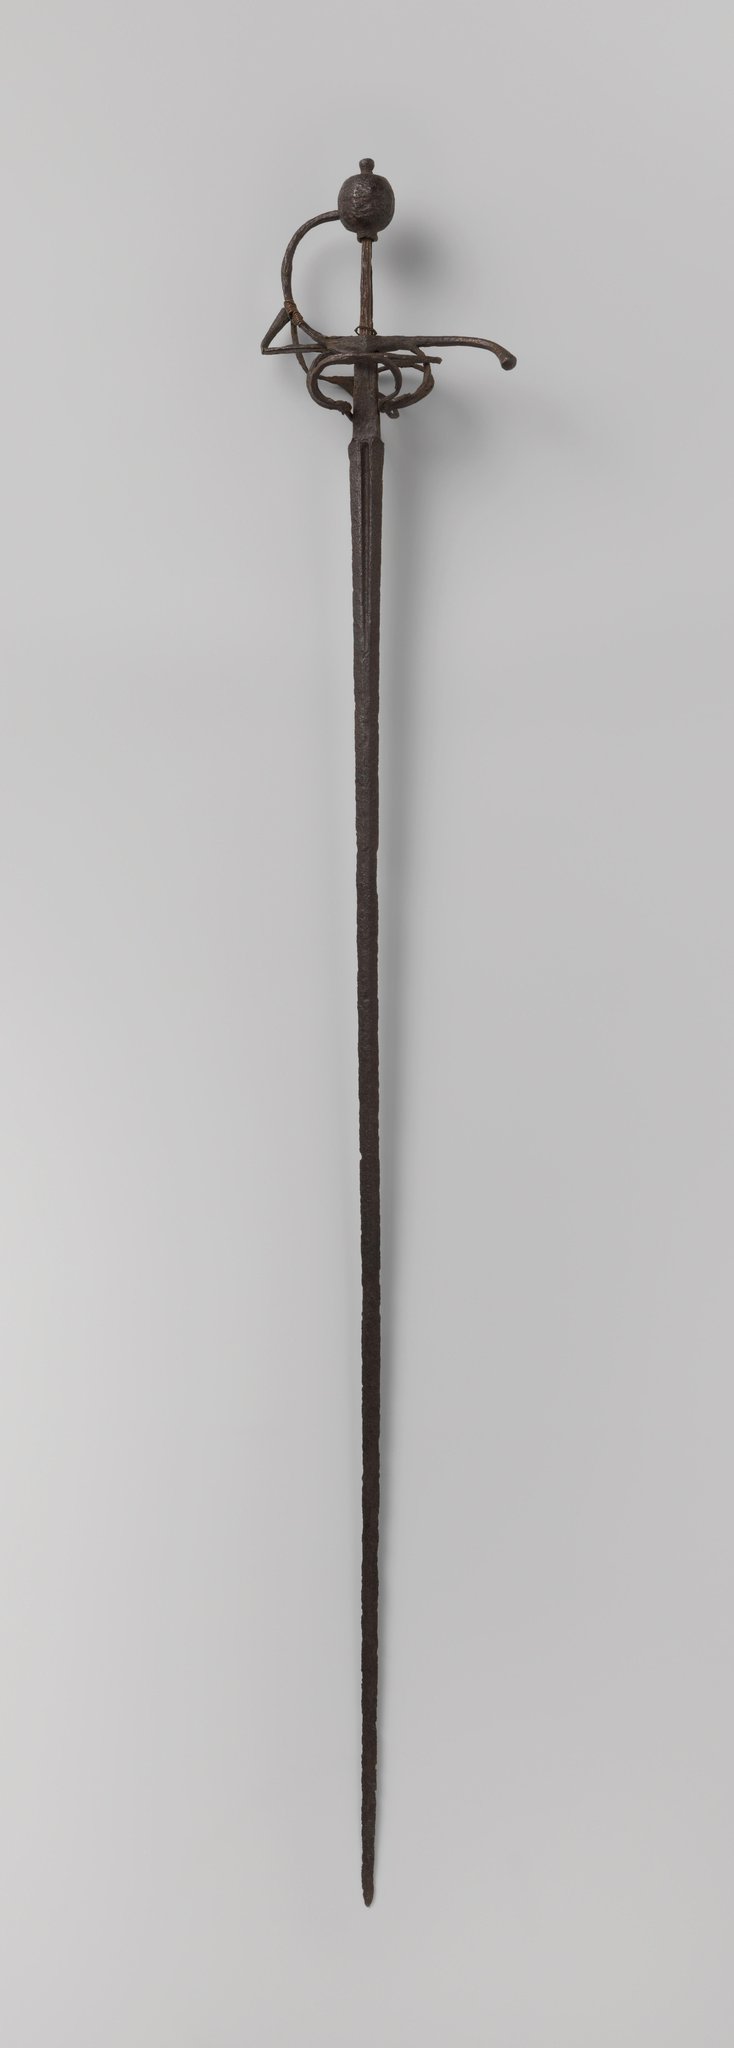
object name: sword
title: Degen met bewerkte garde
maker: Anonymous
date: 1500-1600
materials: iron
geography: europe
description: Degen. De kling aan het achtereinde gegroefd. Het gevest heeft een lange rechte pareerstang, waarvan de uiteinden even zijwaarts zijn omgebogen. Schutbeugel (pas j'âne) en drie dubbele pareerbeugel. Zwaar door roest beschadigd. Lengte van de kling 1.065. Eind 16de of begin 17de eeuw.